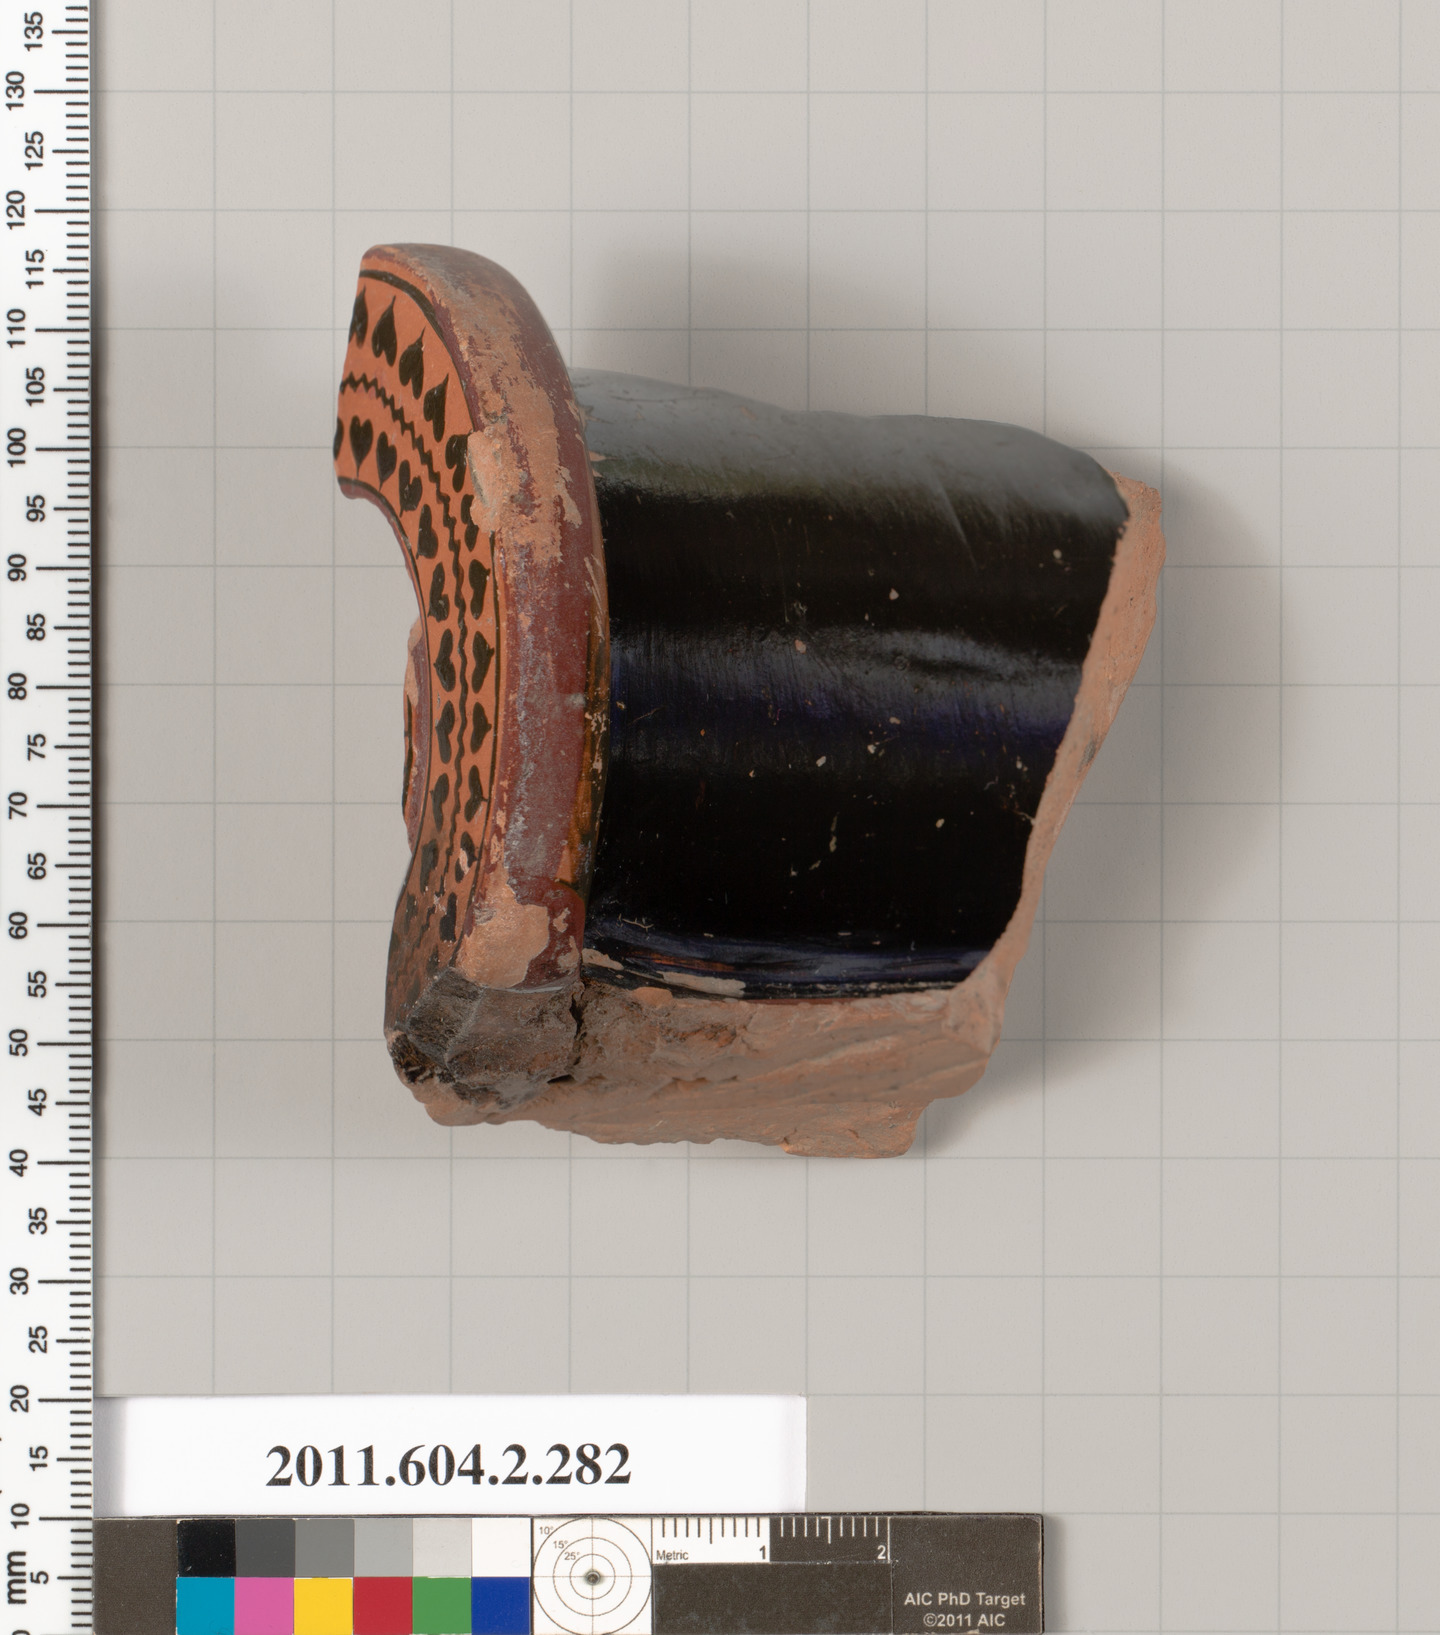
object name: volute krater fragment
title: Terracotta fragment of a volute-krater (bowl for mixing wine and water)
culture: greek, attic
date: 534-468 BCE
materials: terracotta